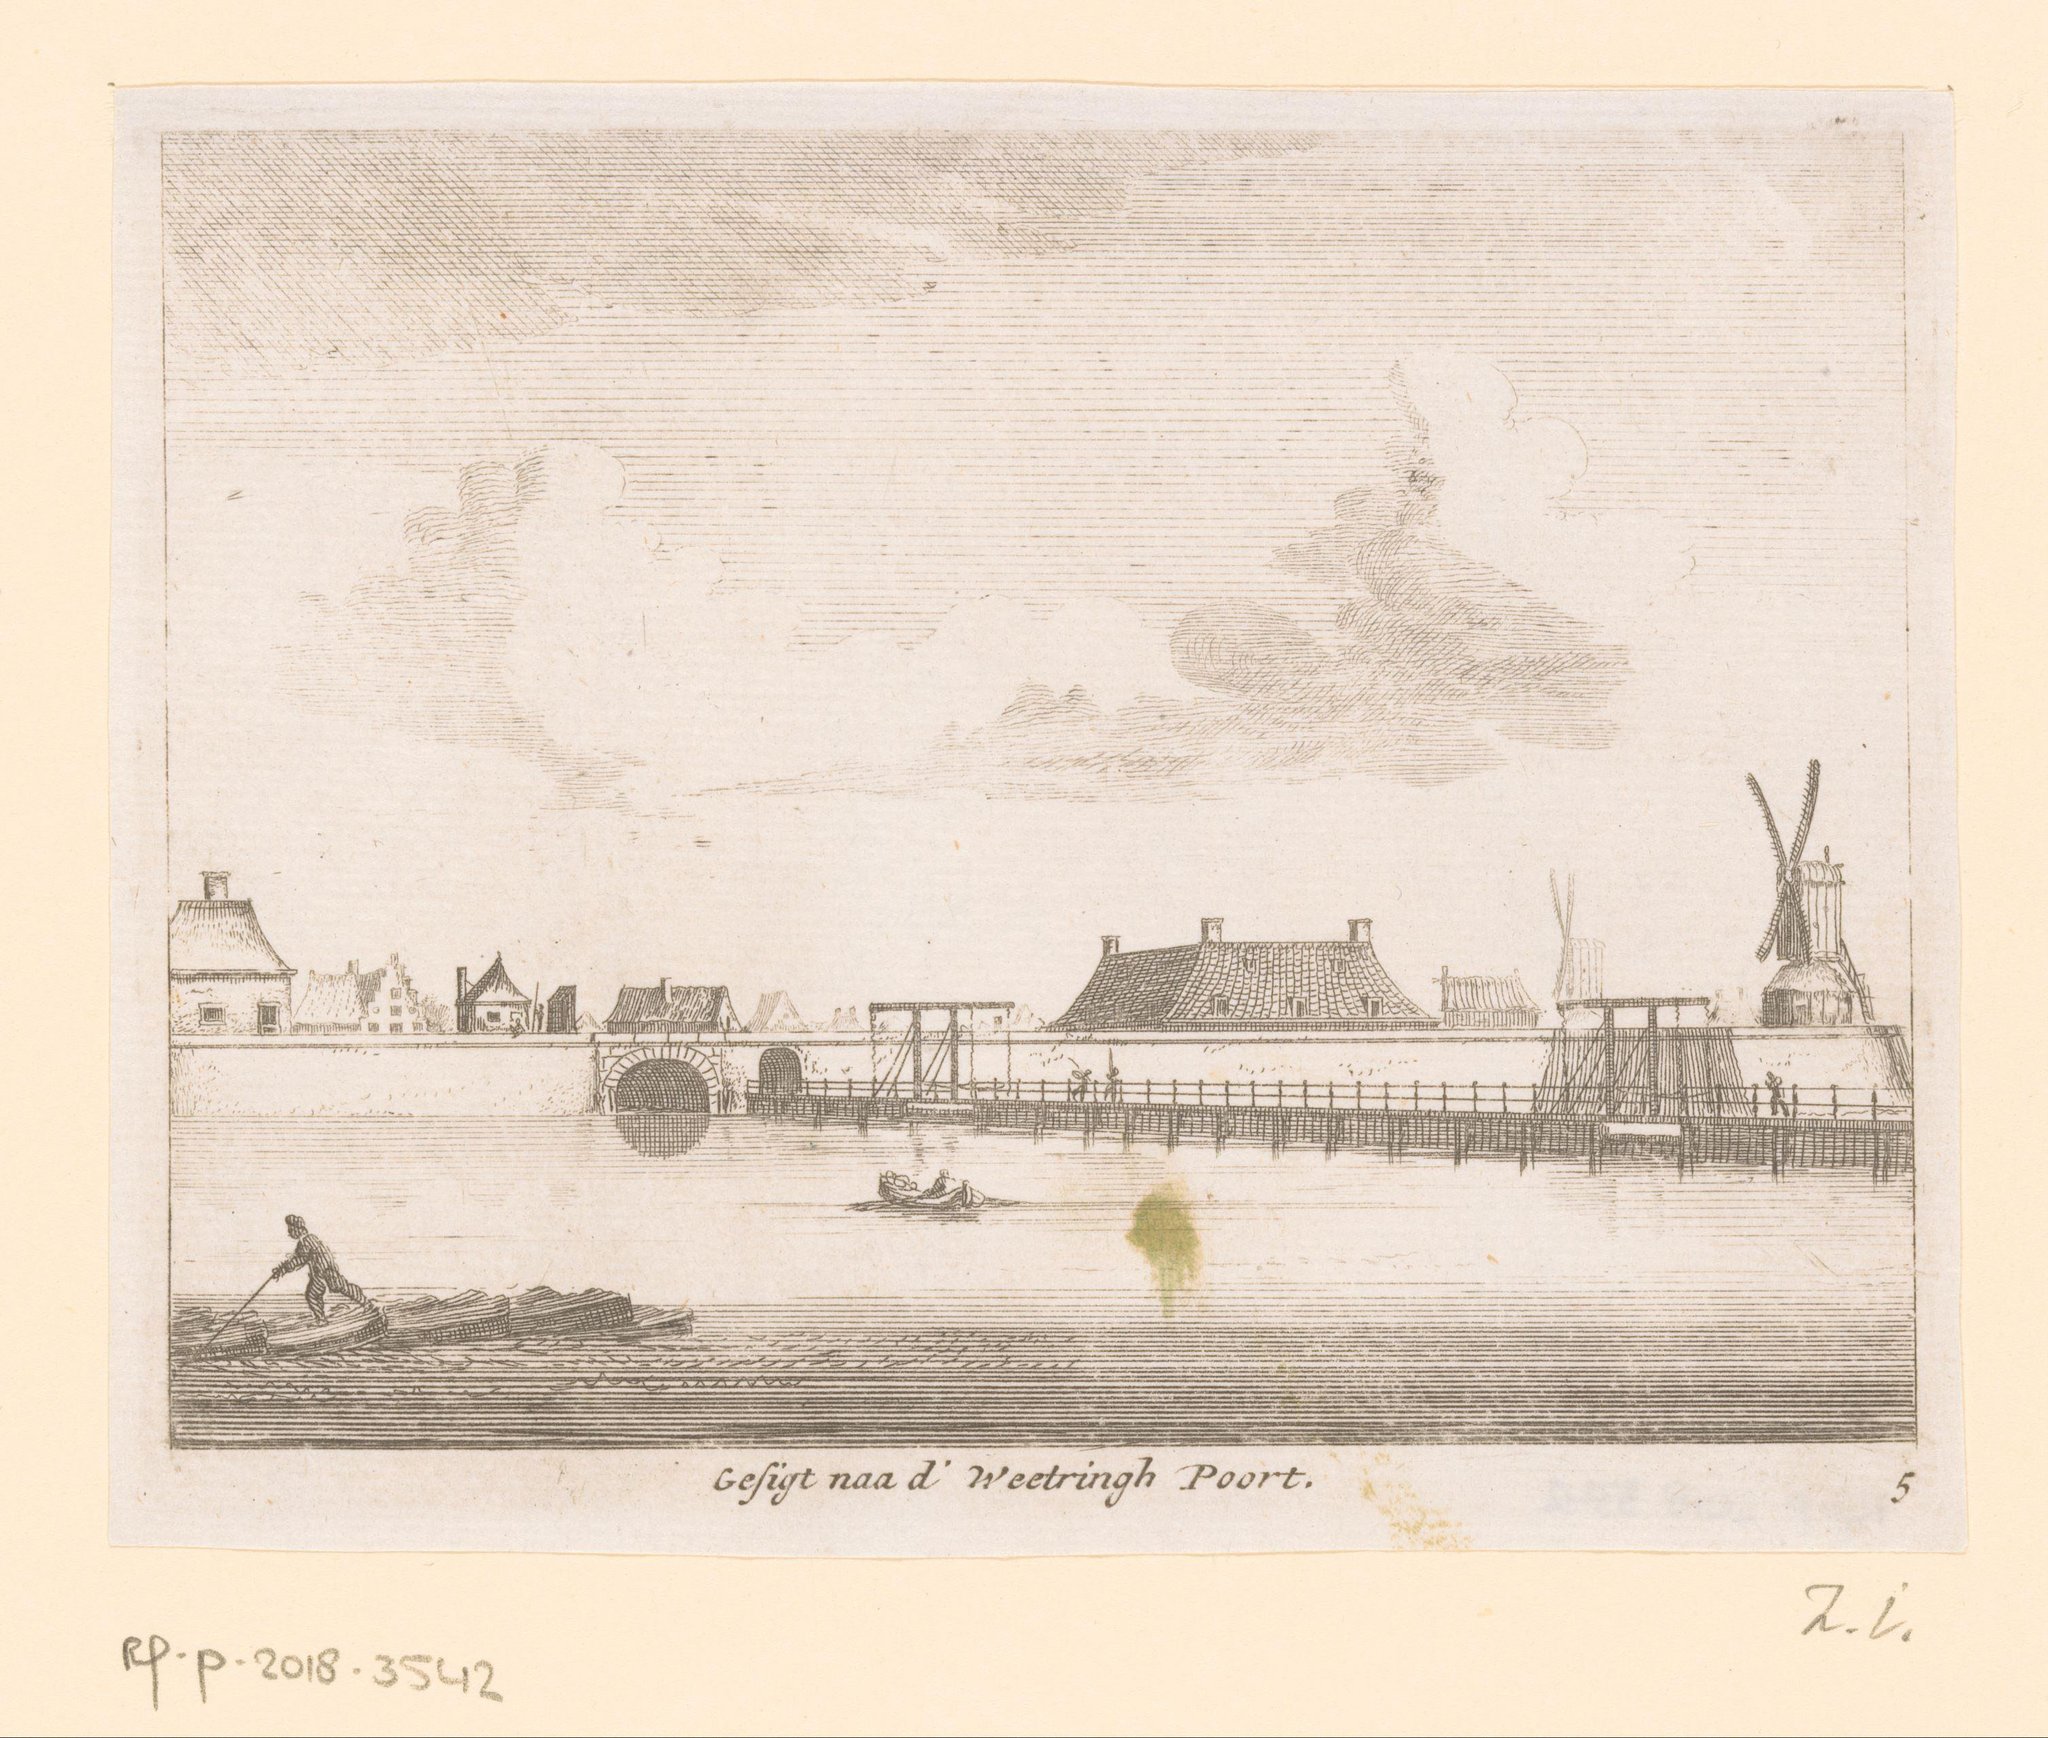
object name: print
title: Gezicht op de Weteringpoort in Amsterdam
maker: Anonymous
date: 1650-1750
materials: paper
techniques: engraving, etching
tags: improvised and unusual traffic on the water, bridge in city across river, canal, etc., city-gate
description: De stadswal met de Weteringpoort, gezien over de Singelgracht. Rechts van het midden het dak van het Verbeterhuis. Geheel rechts molen de Wetering. Rechts vooraan de brug tussen Weteringpoort en Boerenwetering. Links vooraan een man op houtvlot. Rechtsonder nummer: 5.